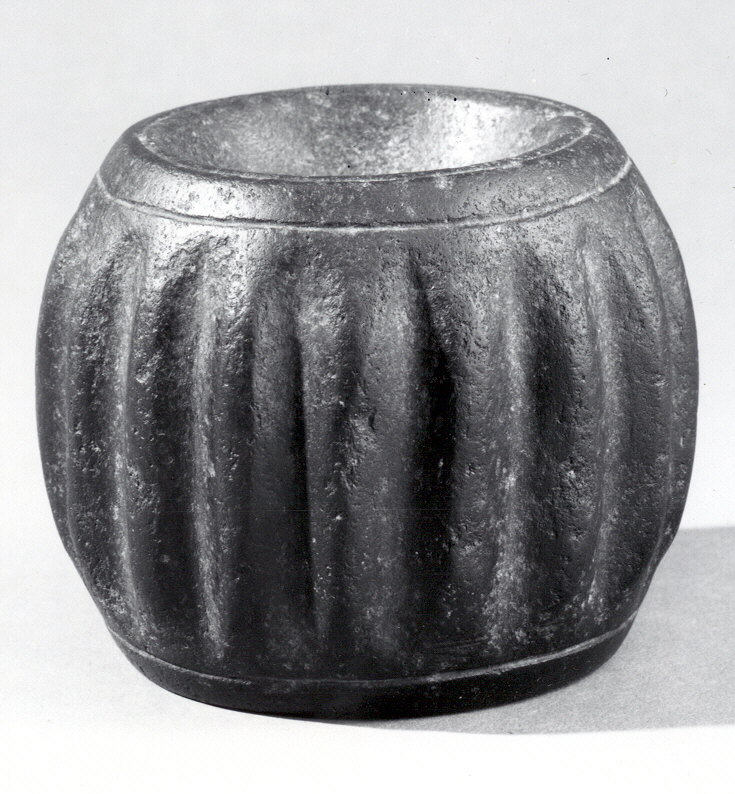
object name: mortar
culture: columbia river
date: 1701-1800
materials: stone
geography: united states